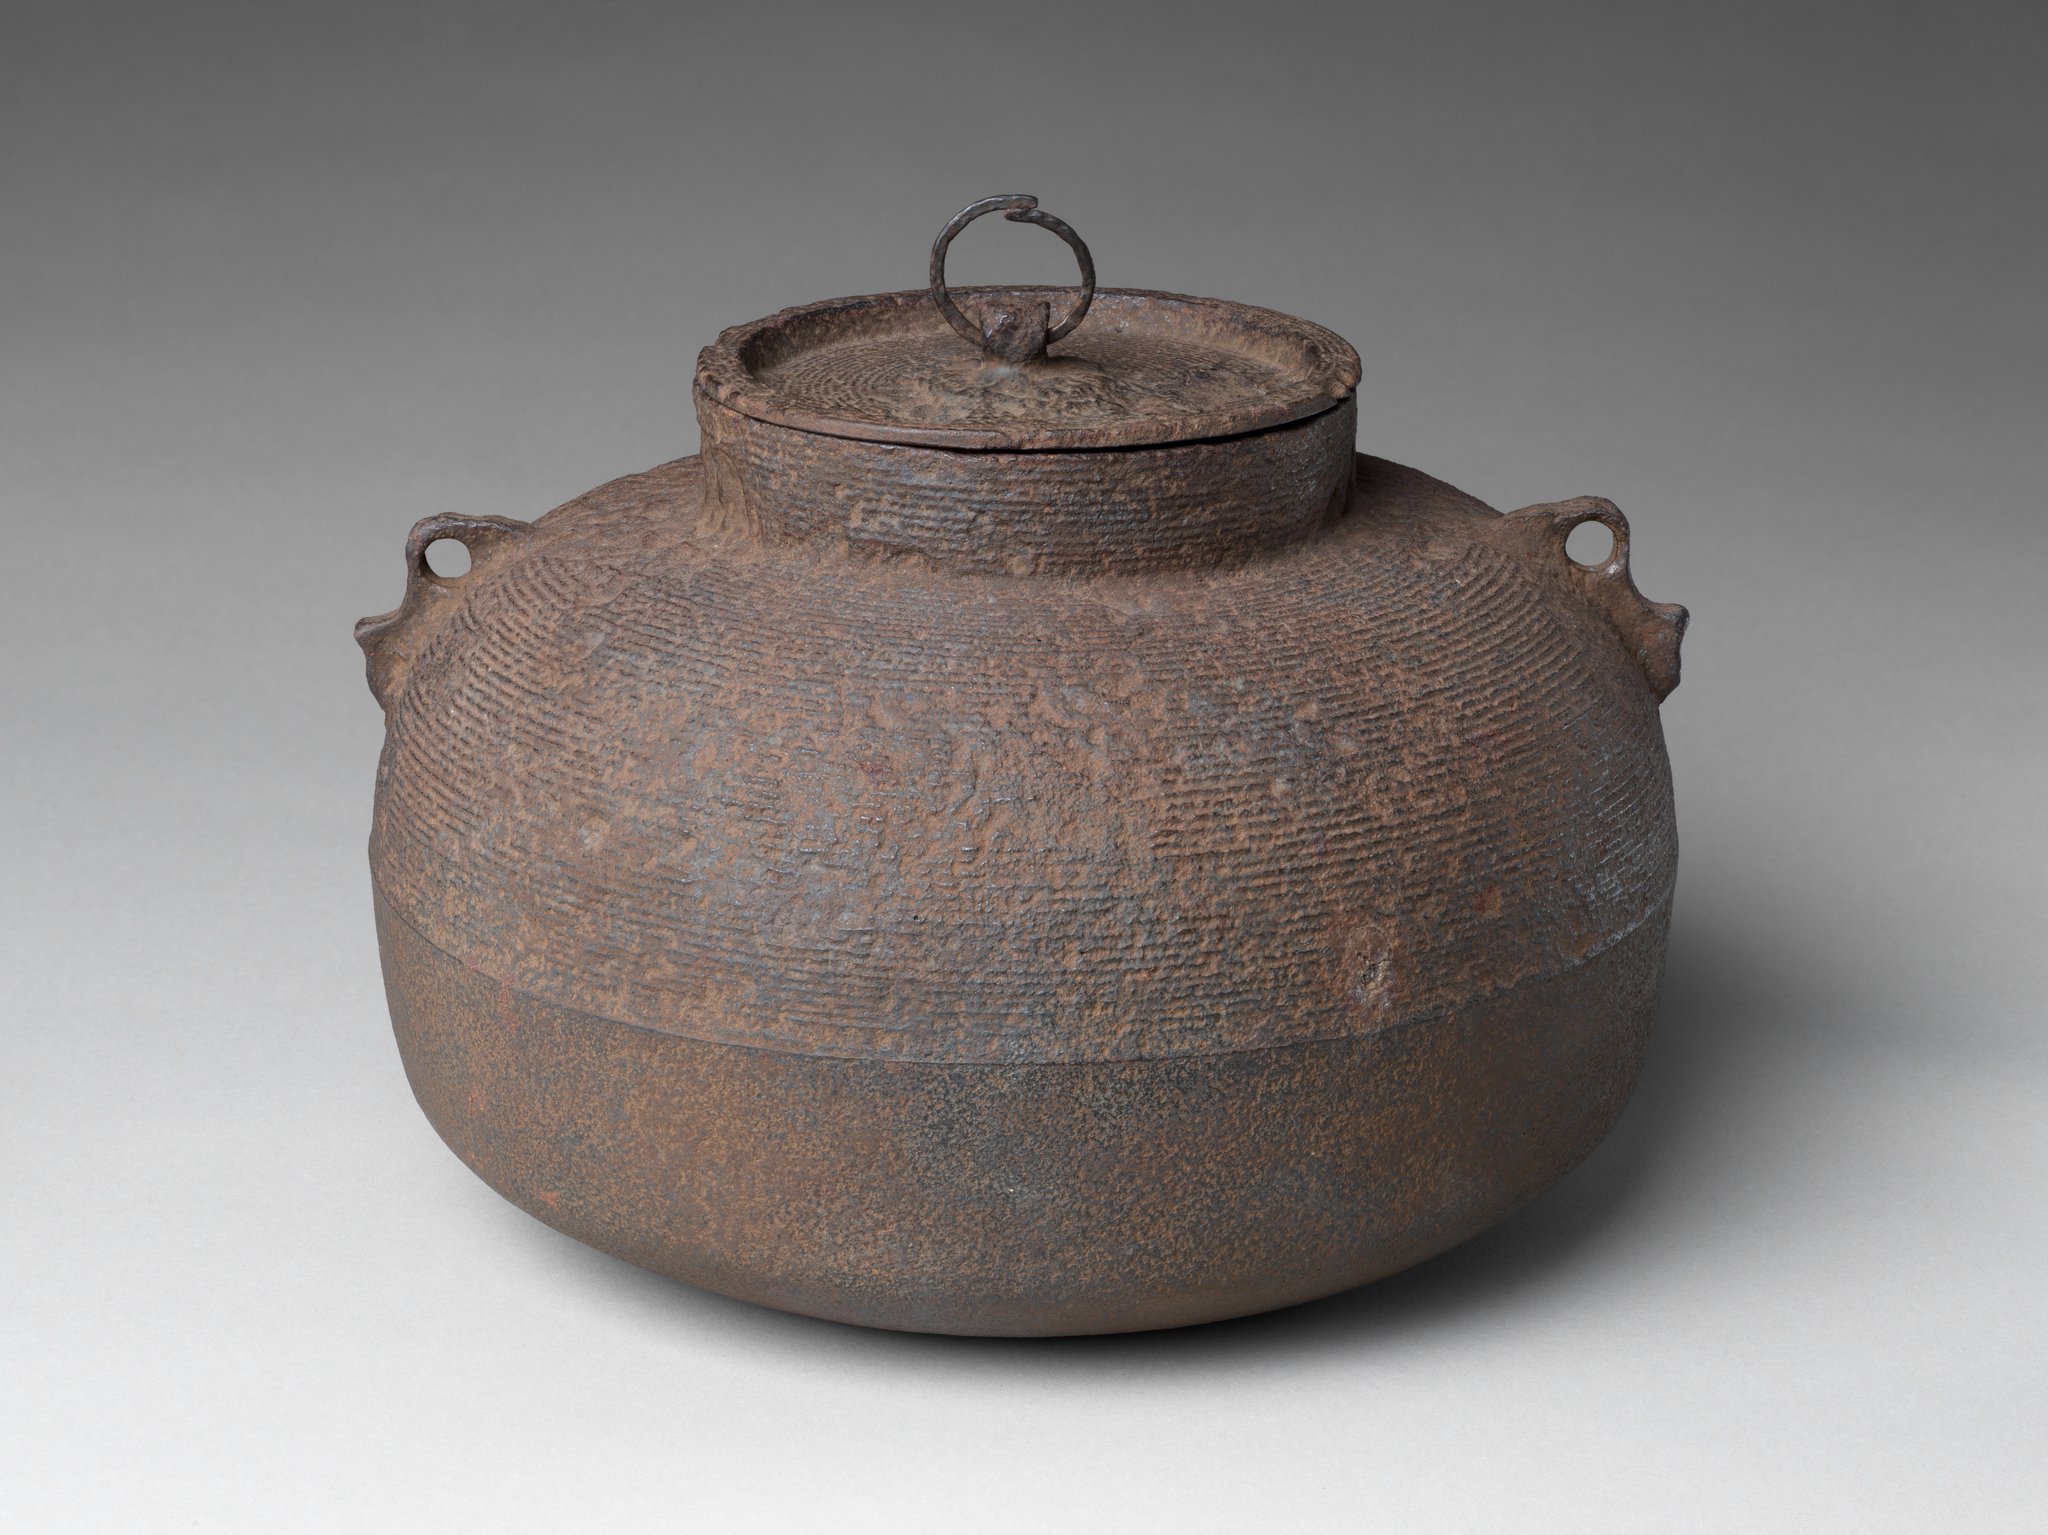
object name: kettle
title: Temmyô-type Kettle, known as Taya Itome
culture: japanese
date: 1501-1600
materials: iron